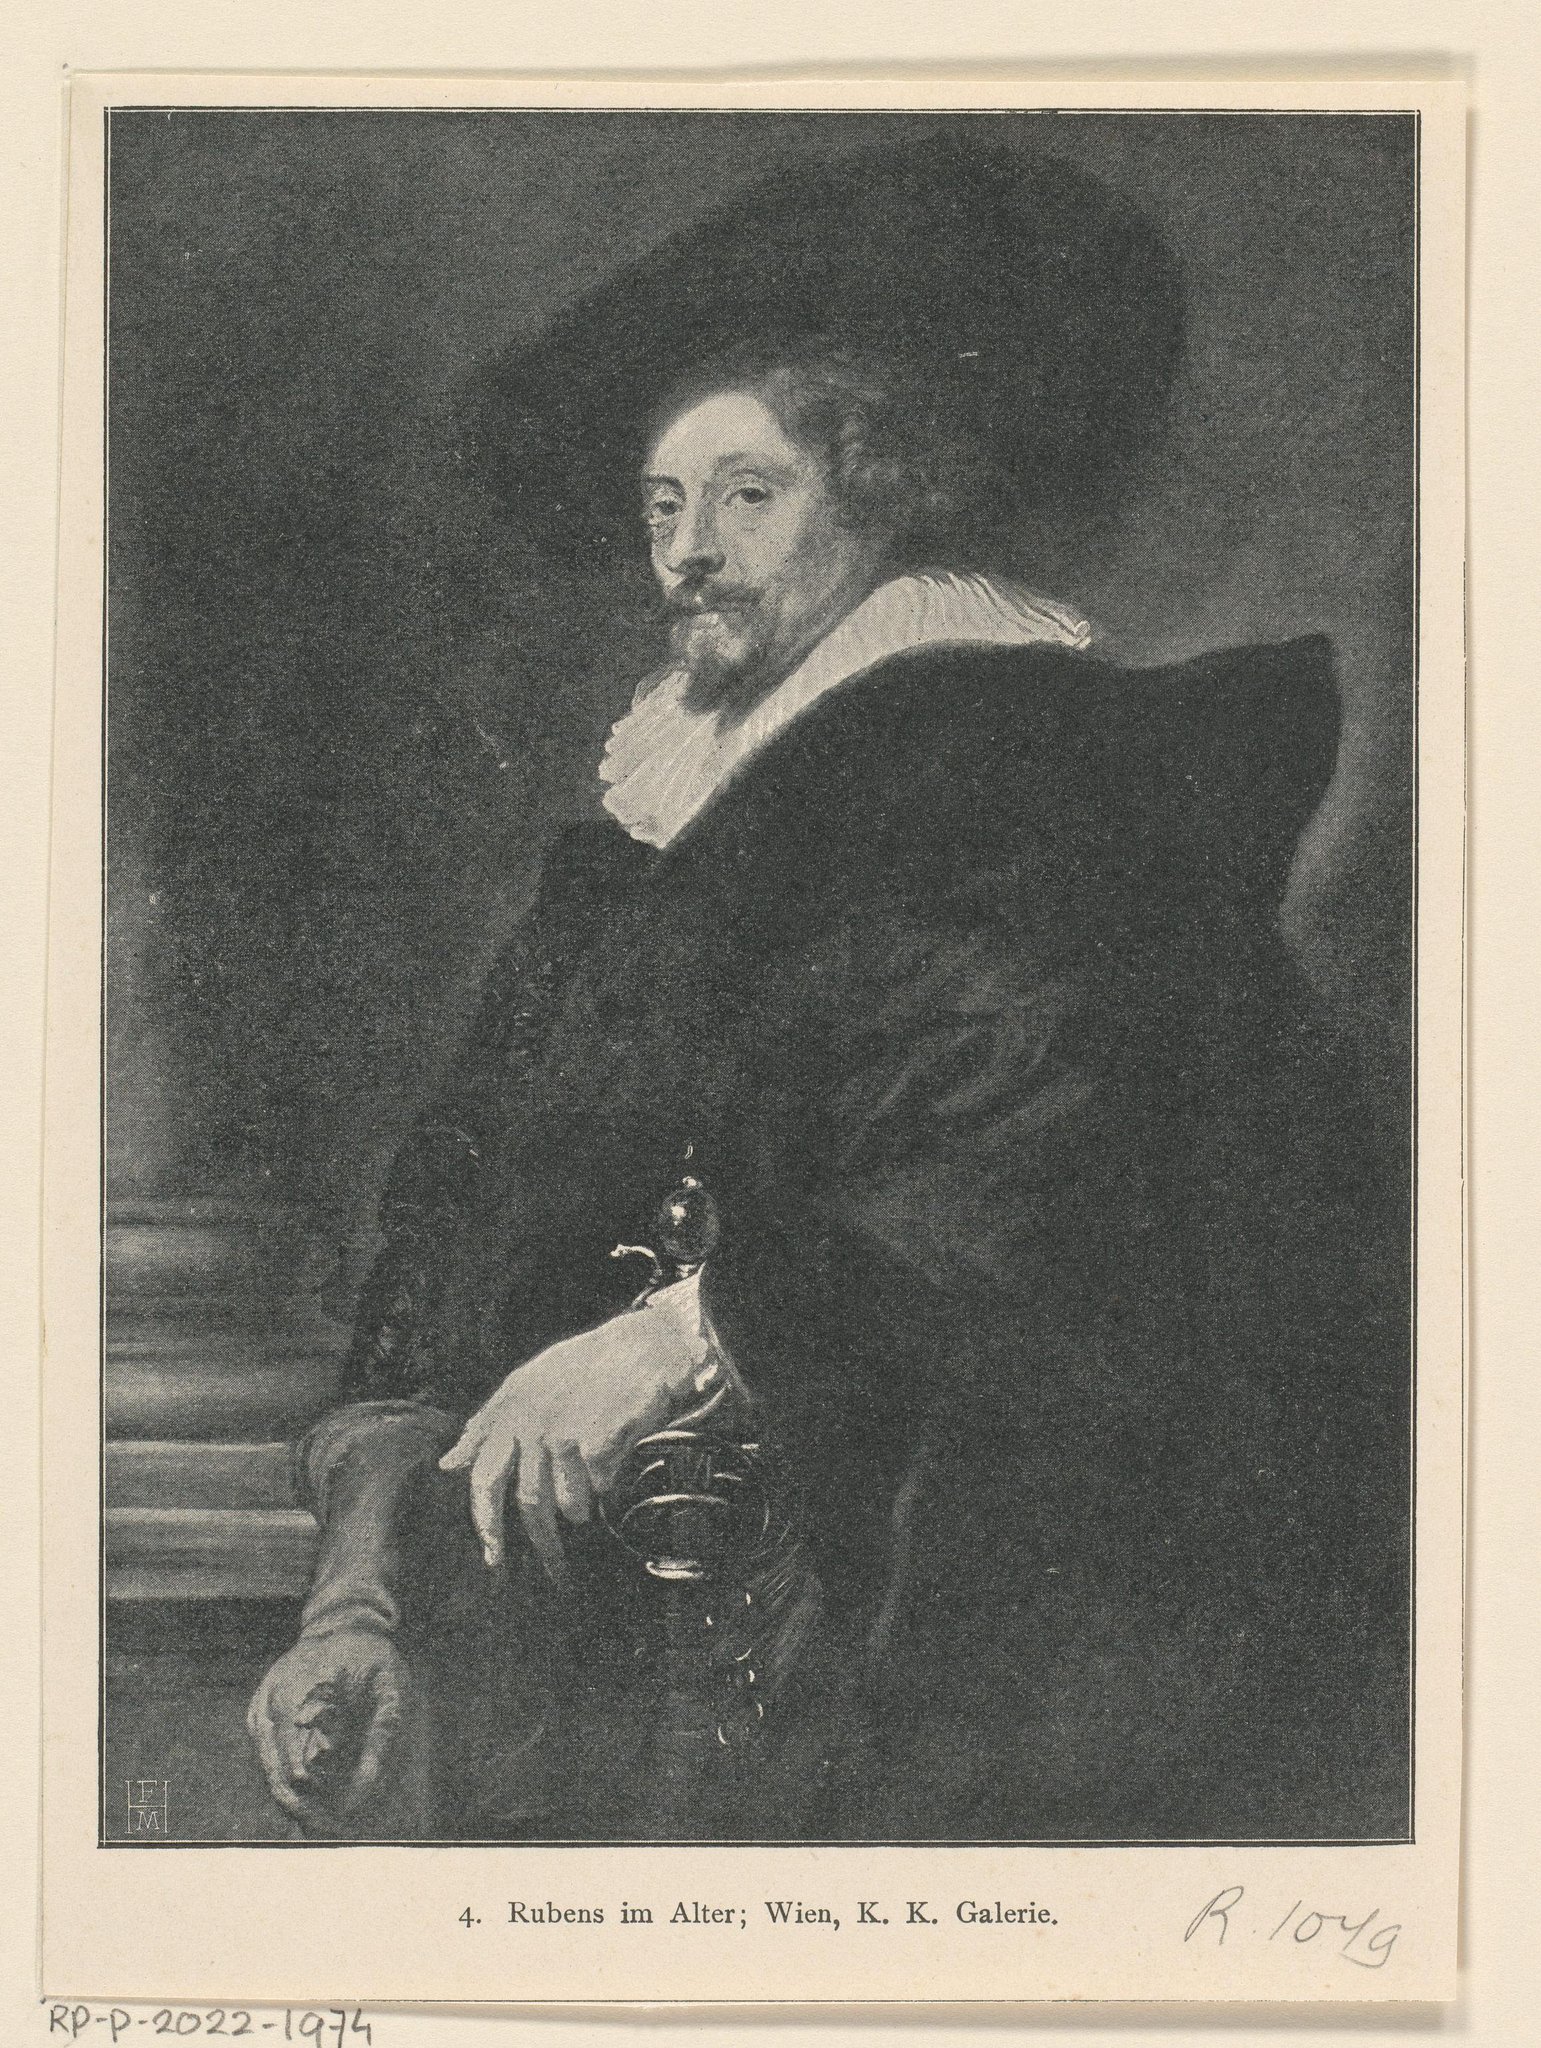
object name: photomechanical print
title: Portret van Peter Paul Rubens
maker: Anonymous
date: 1882-1970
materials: paper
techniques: autotype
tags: antwerp, painter, print maker, draughtsman, peter paul rubens, historical persons, portrait, self-portrait of artist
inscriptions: number: ‘R 1049’